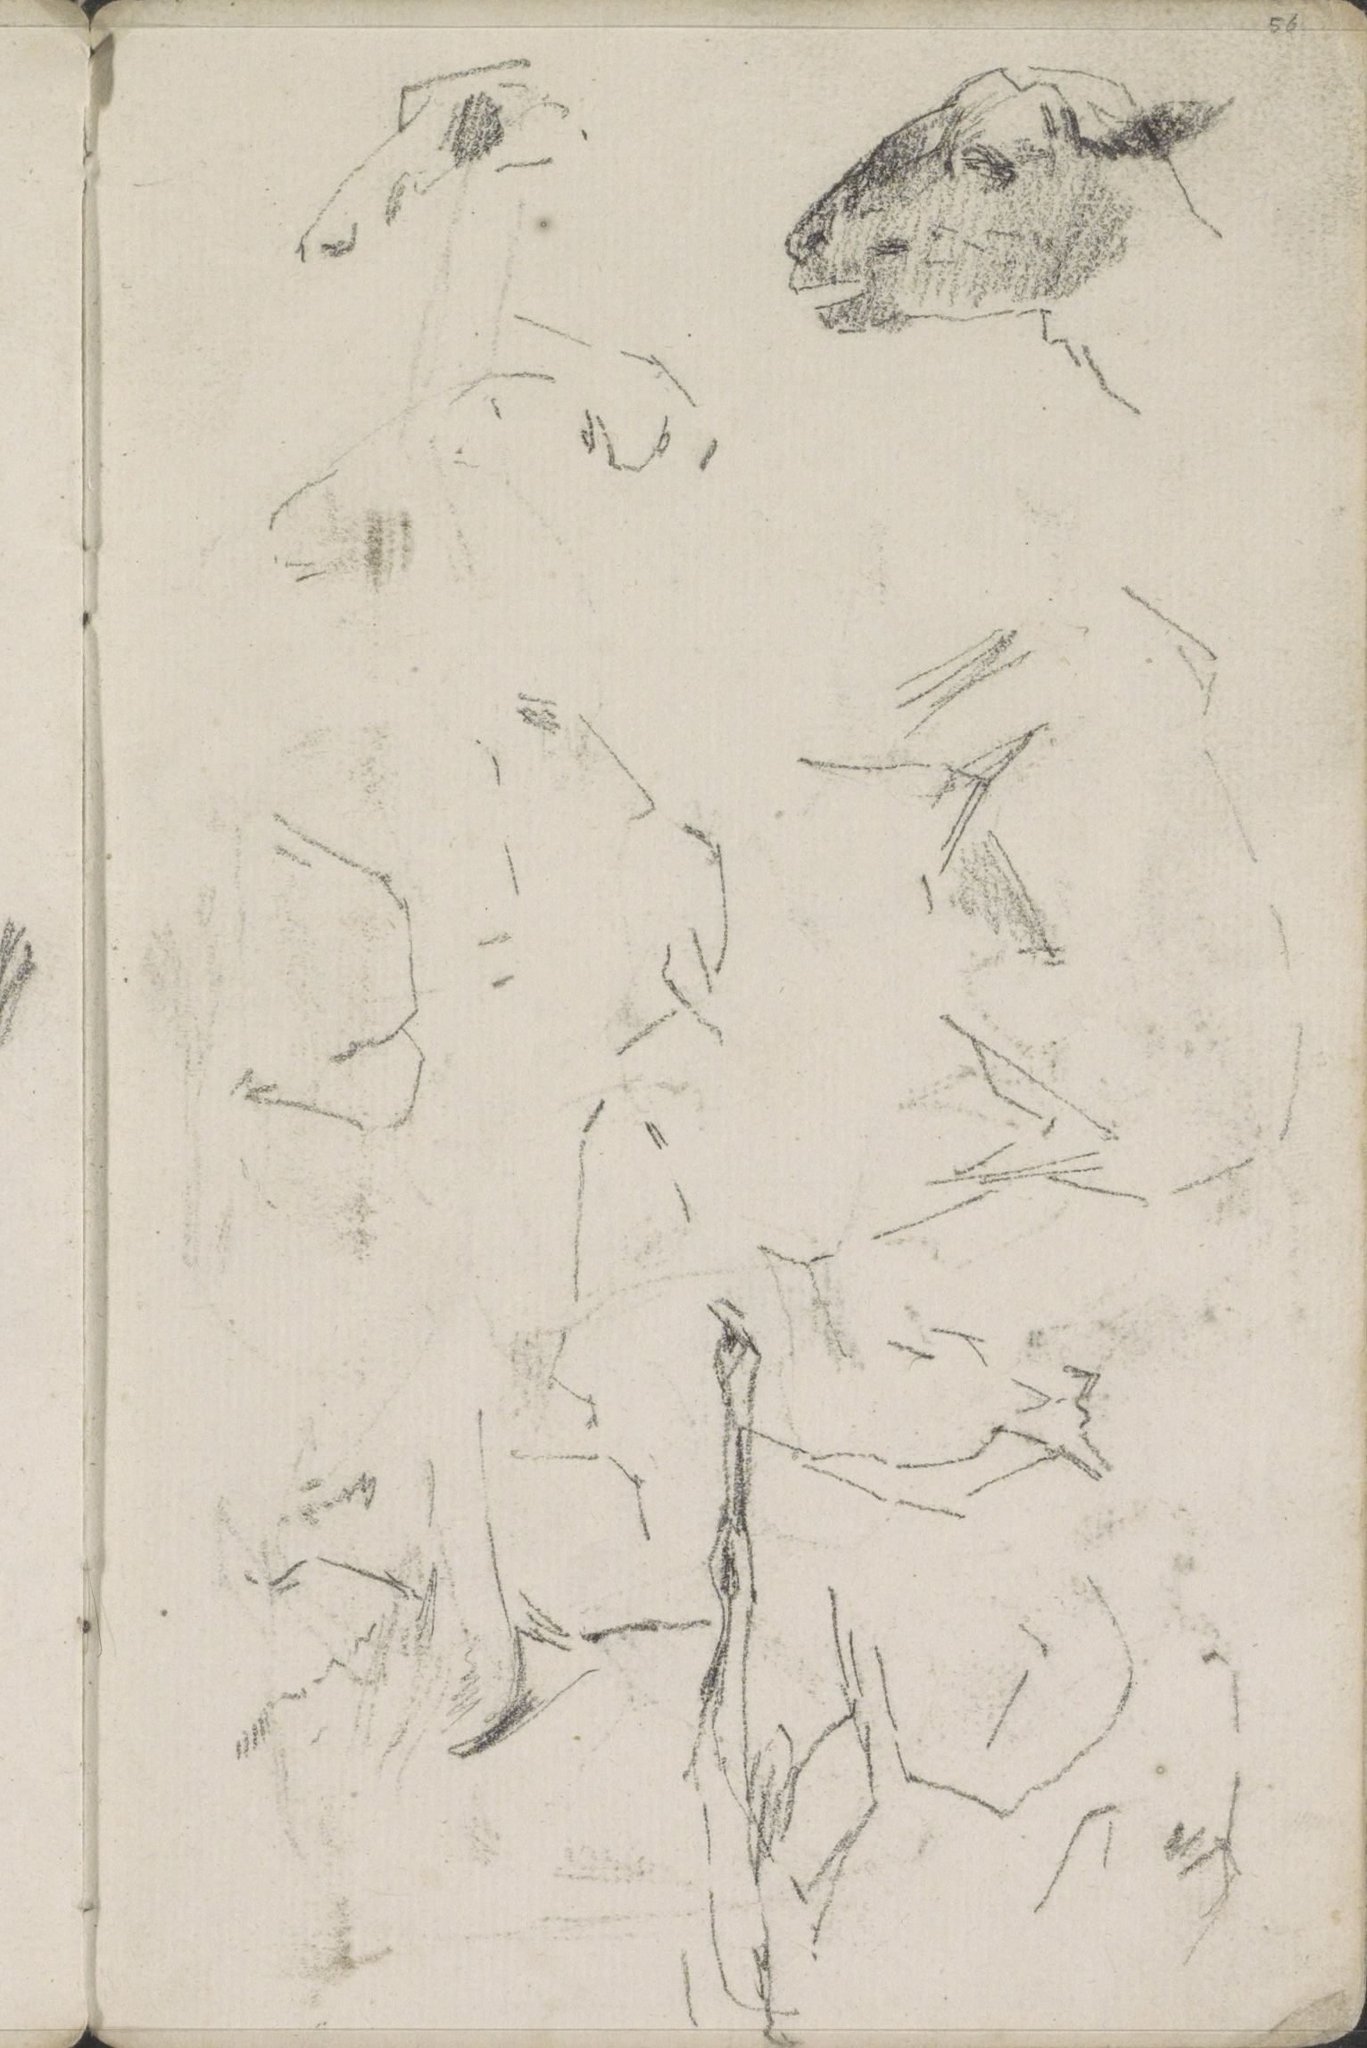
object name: sketchbook leaf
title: Dieren, mogelijk schapen of geiten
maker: george hendrik breitner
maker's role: draughtsman, painter, print maker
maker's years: 1857-1923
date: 1880-1882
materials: chalk, paper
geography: the hague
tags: sheep, goat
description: Pagina 56 uit een schetsboek met 29 bladen.